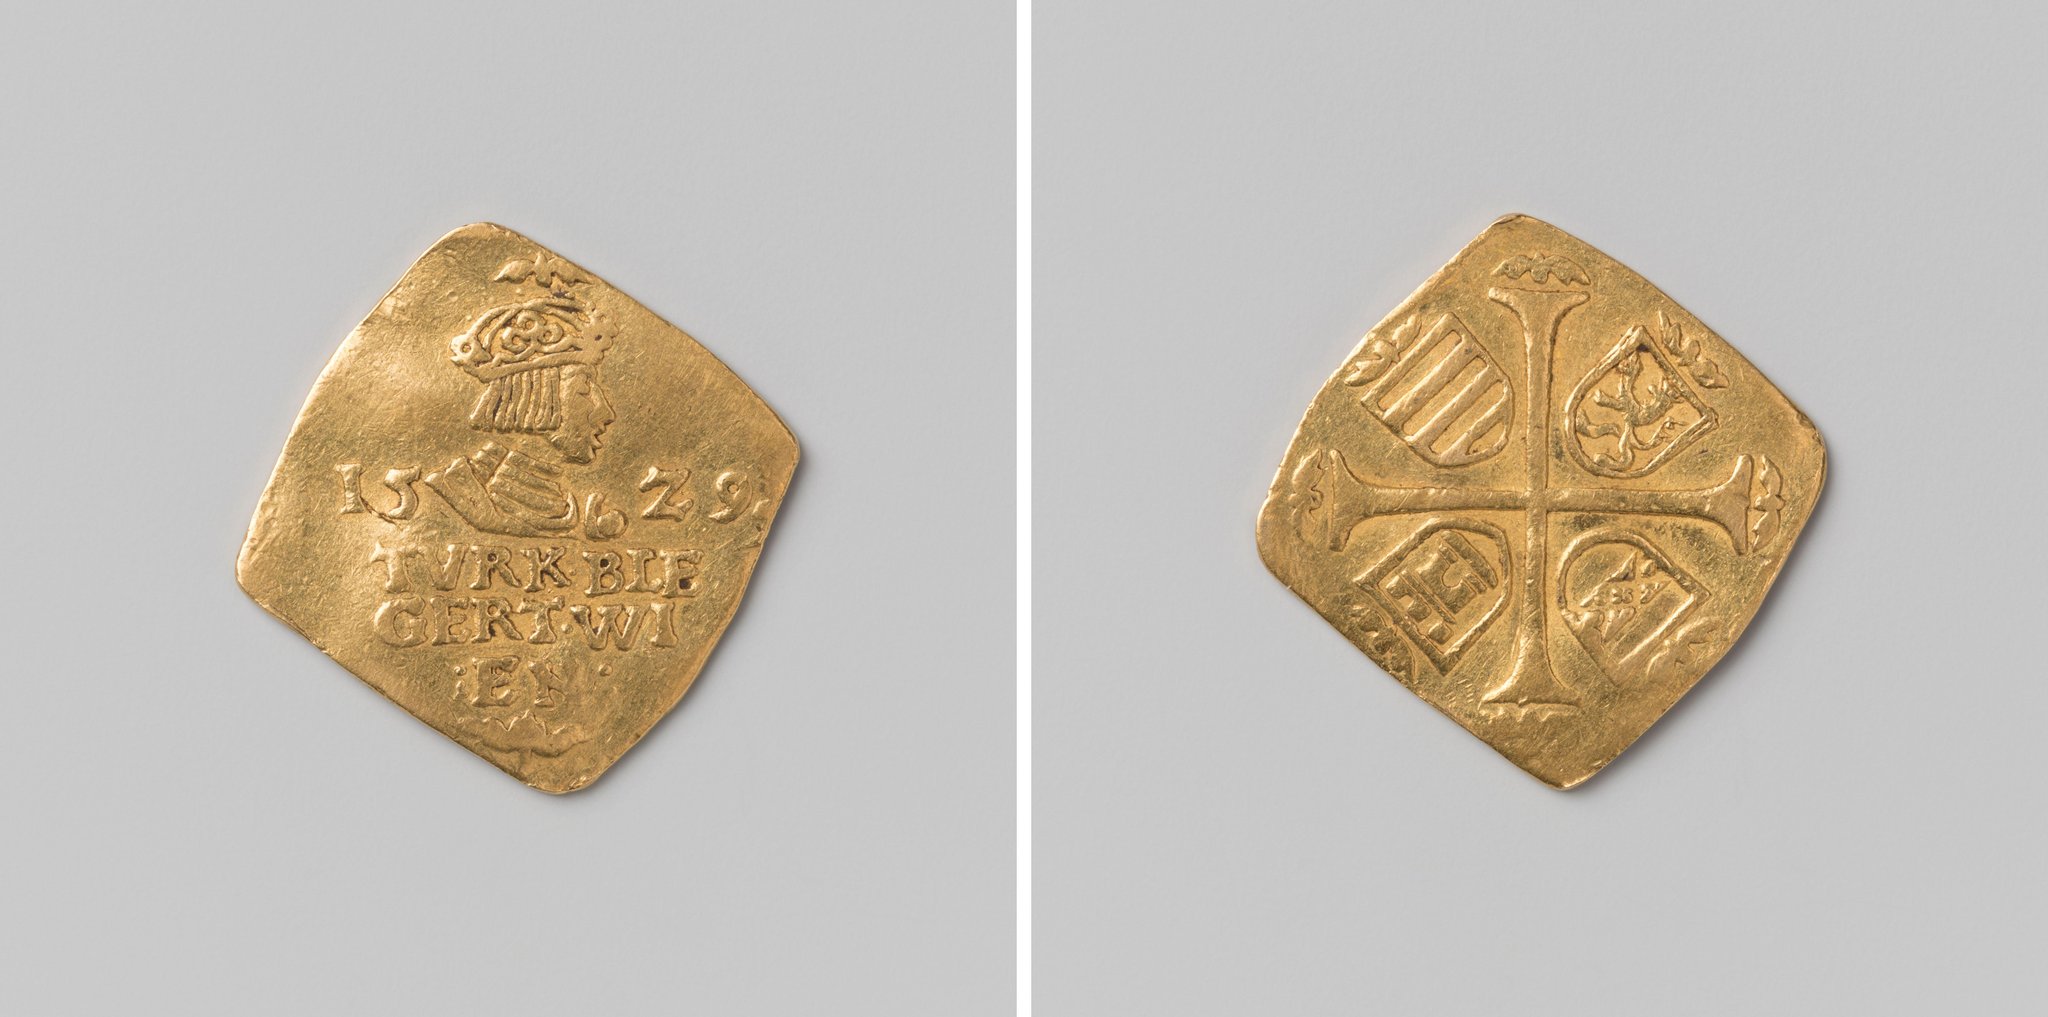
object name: gouden dukaat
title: Gouden dukaat, noodmunt uit Wenen, geslagen tijdens het beleg door de Turken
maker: Anonymous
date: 1529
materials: gold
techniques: striking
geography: vienna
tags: vienna, ferdinand i van habsburg (duits keizer)